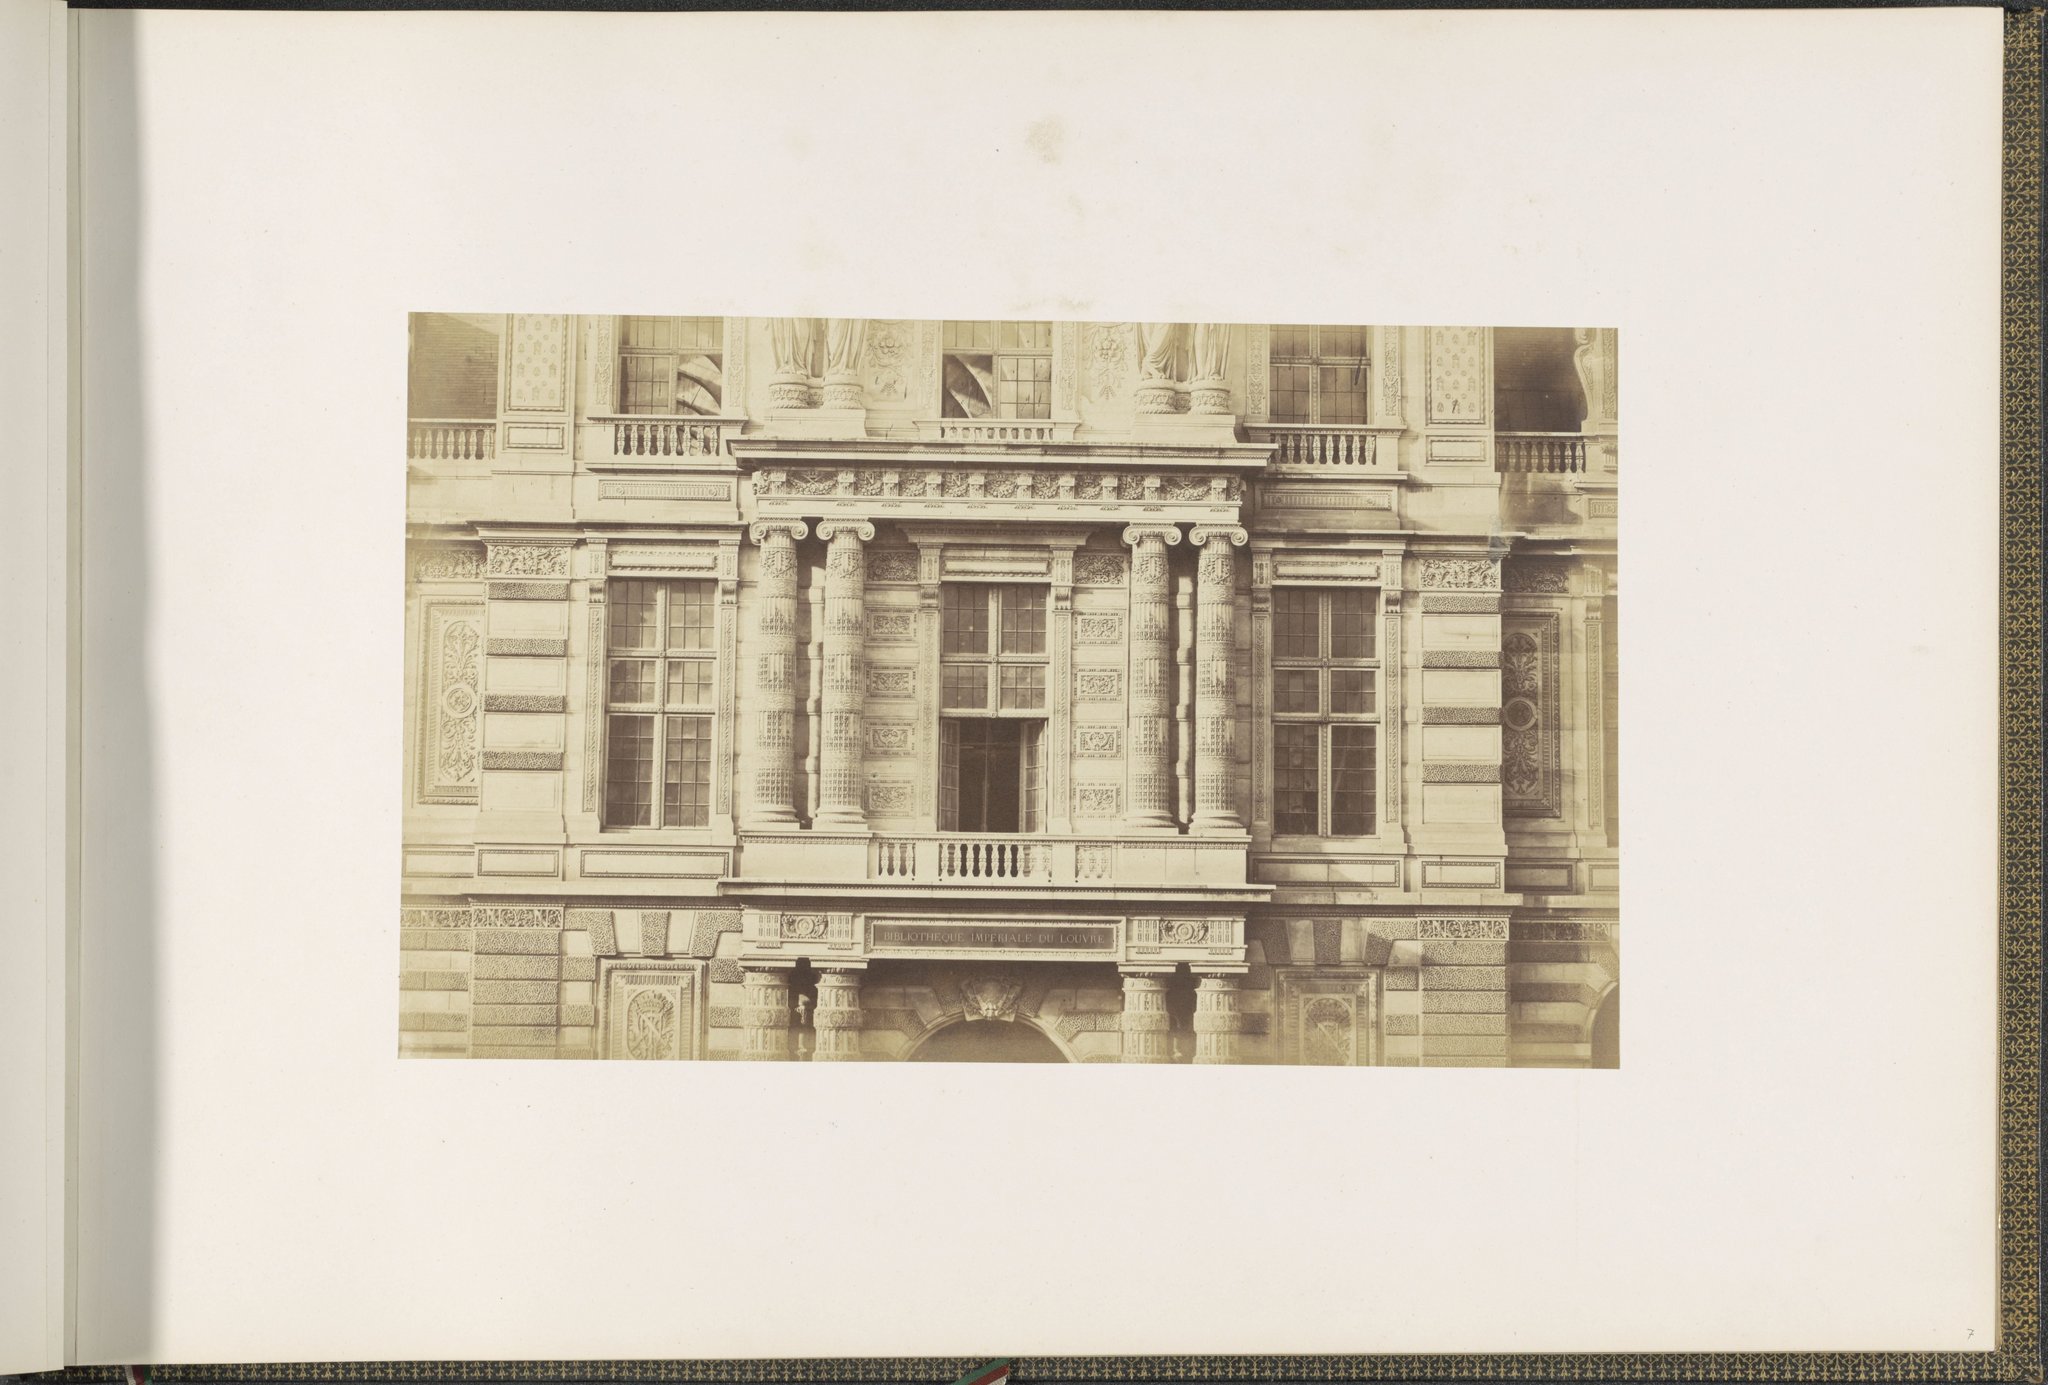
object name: photograph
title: Eerste verdieping van de Bibliothèque Impériale in het Palais du Louvre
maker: édouard denis baldus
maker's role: fotograaf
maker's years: 1813-1889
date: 1857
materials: paper, photographic support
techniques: salted paper print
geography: paris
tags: permanent exhibition, museum, façade (of house or building), paris, tuileries palace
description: Onderdeel van Réunion des Tuileries au Louvre 1852-1857, album 4.